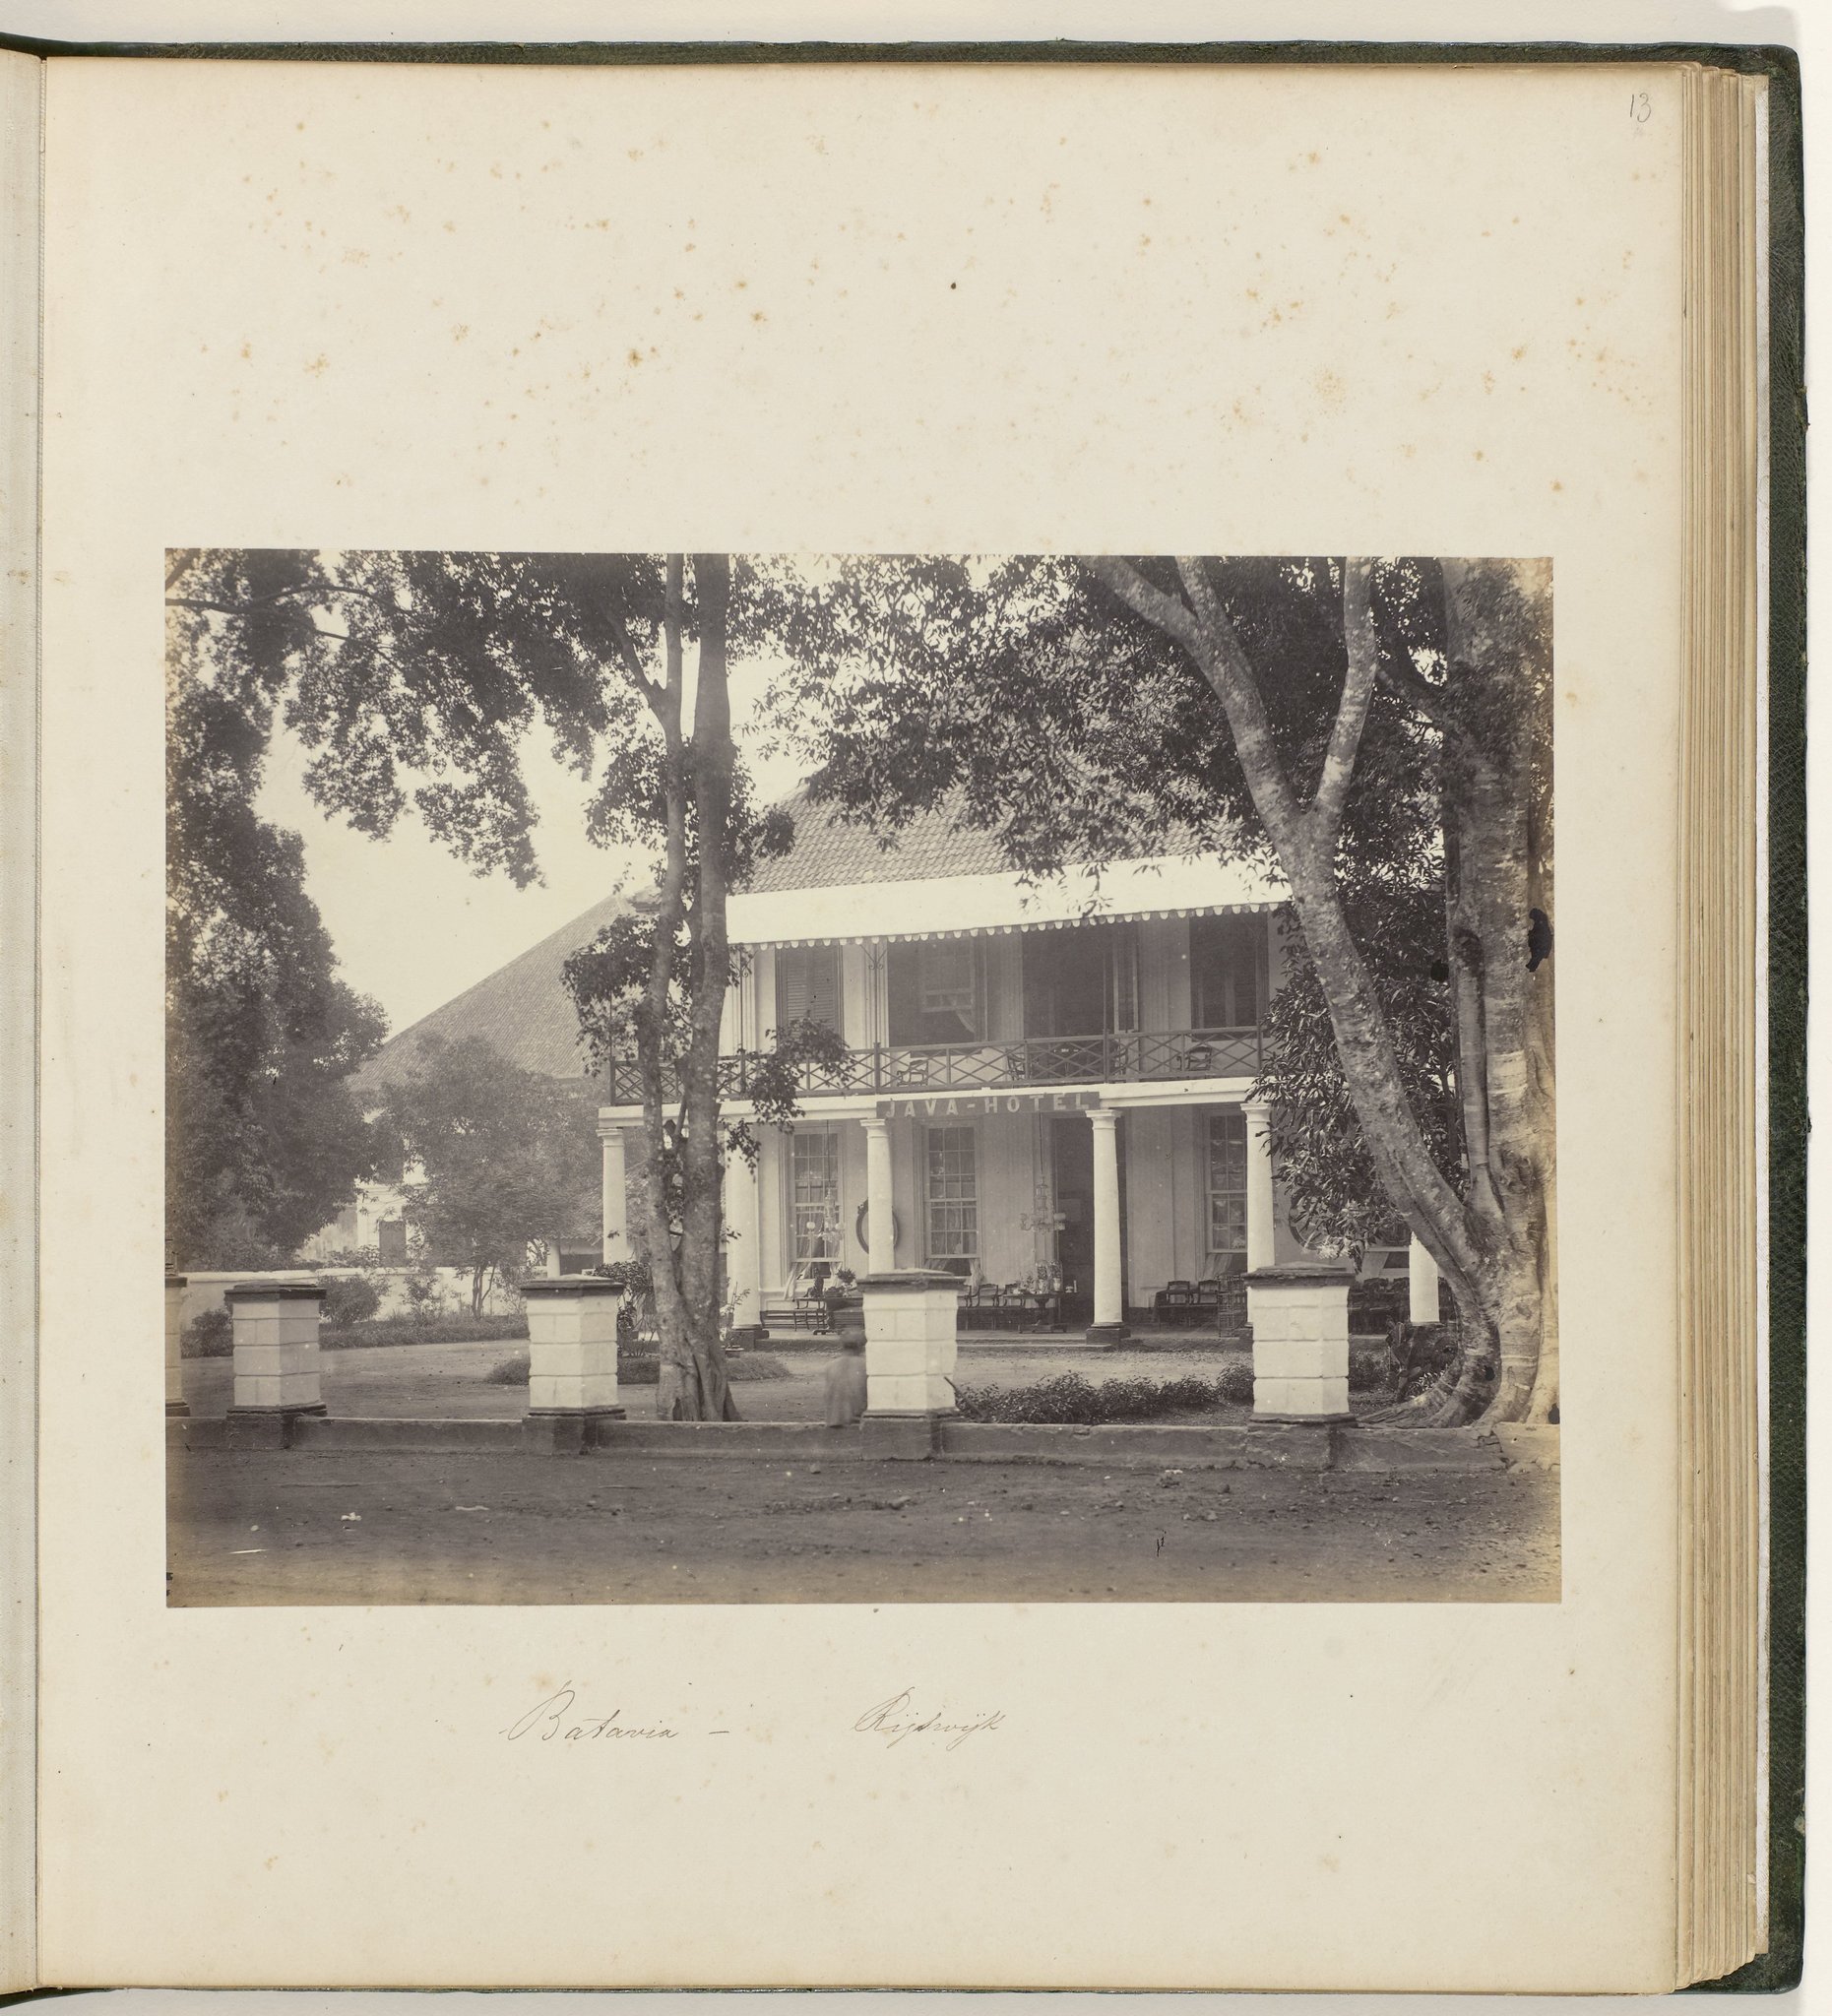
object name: photograph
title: Batavia - Rijswijk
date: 1863-1866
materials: photographic support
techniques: albumen print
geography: batavia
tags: hotel, hostelry, inn, batavia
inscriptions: inscription: ‘Batavia - Rijswijk’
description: Het Java-Hotel (Grand Hotel Java) in Rijswijk te Batavia. Onderdeel van het tweede groene fotoalbum met foto's van Java, uit het bezit van apotheker Specht-Grijp, die in 1865 vanuit Batavia naar Nederland terugkeerde.